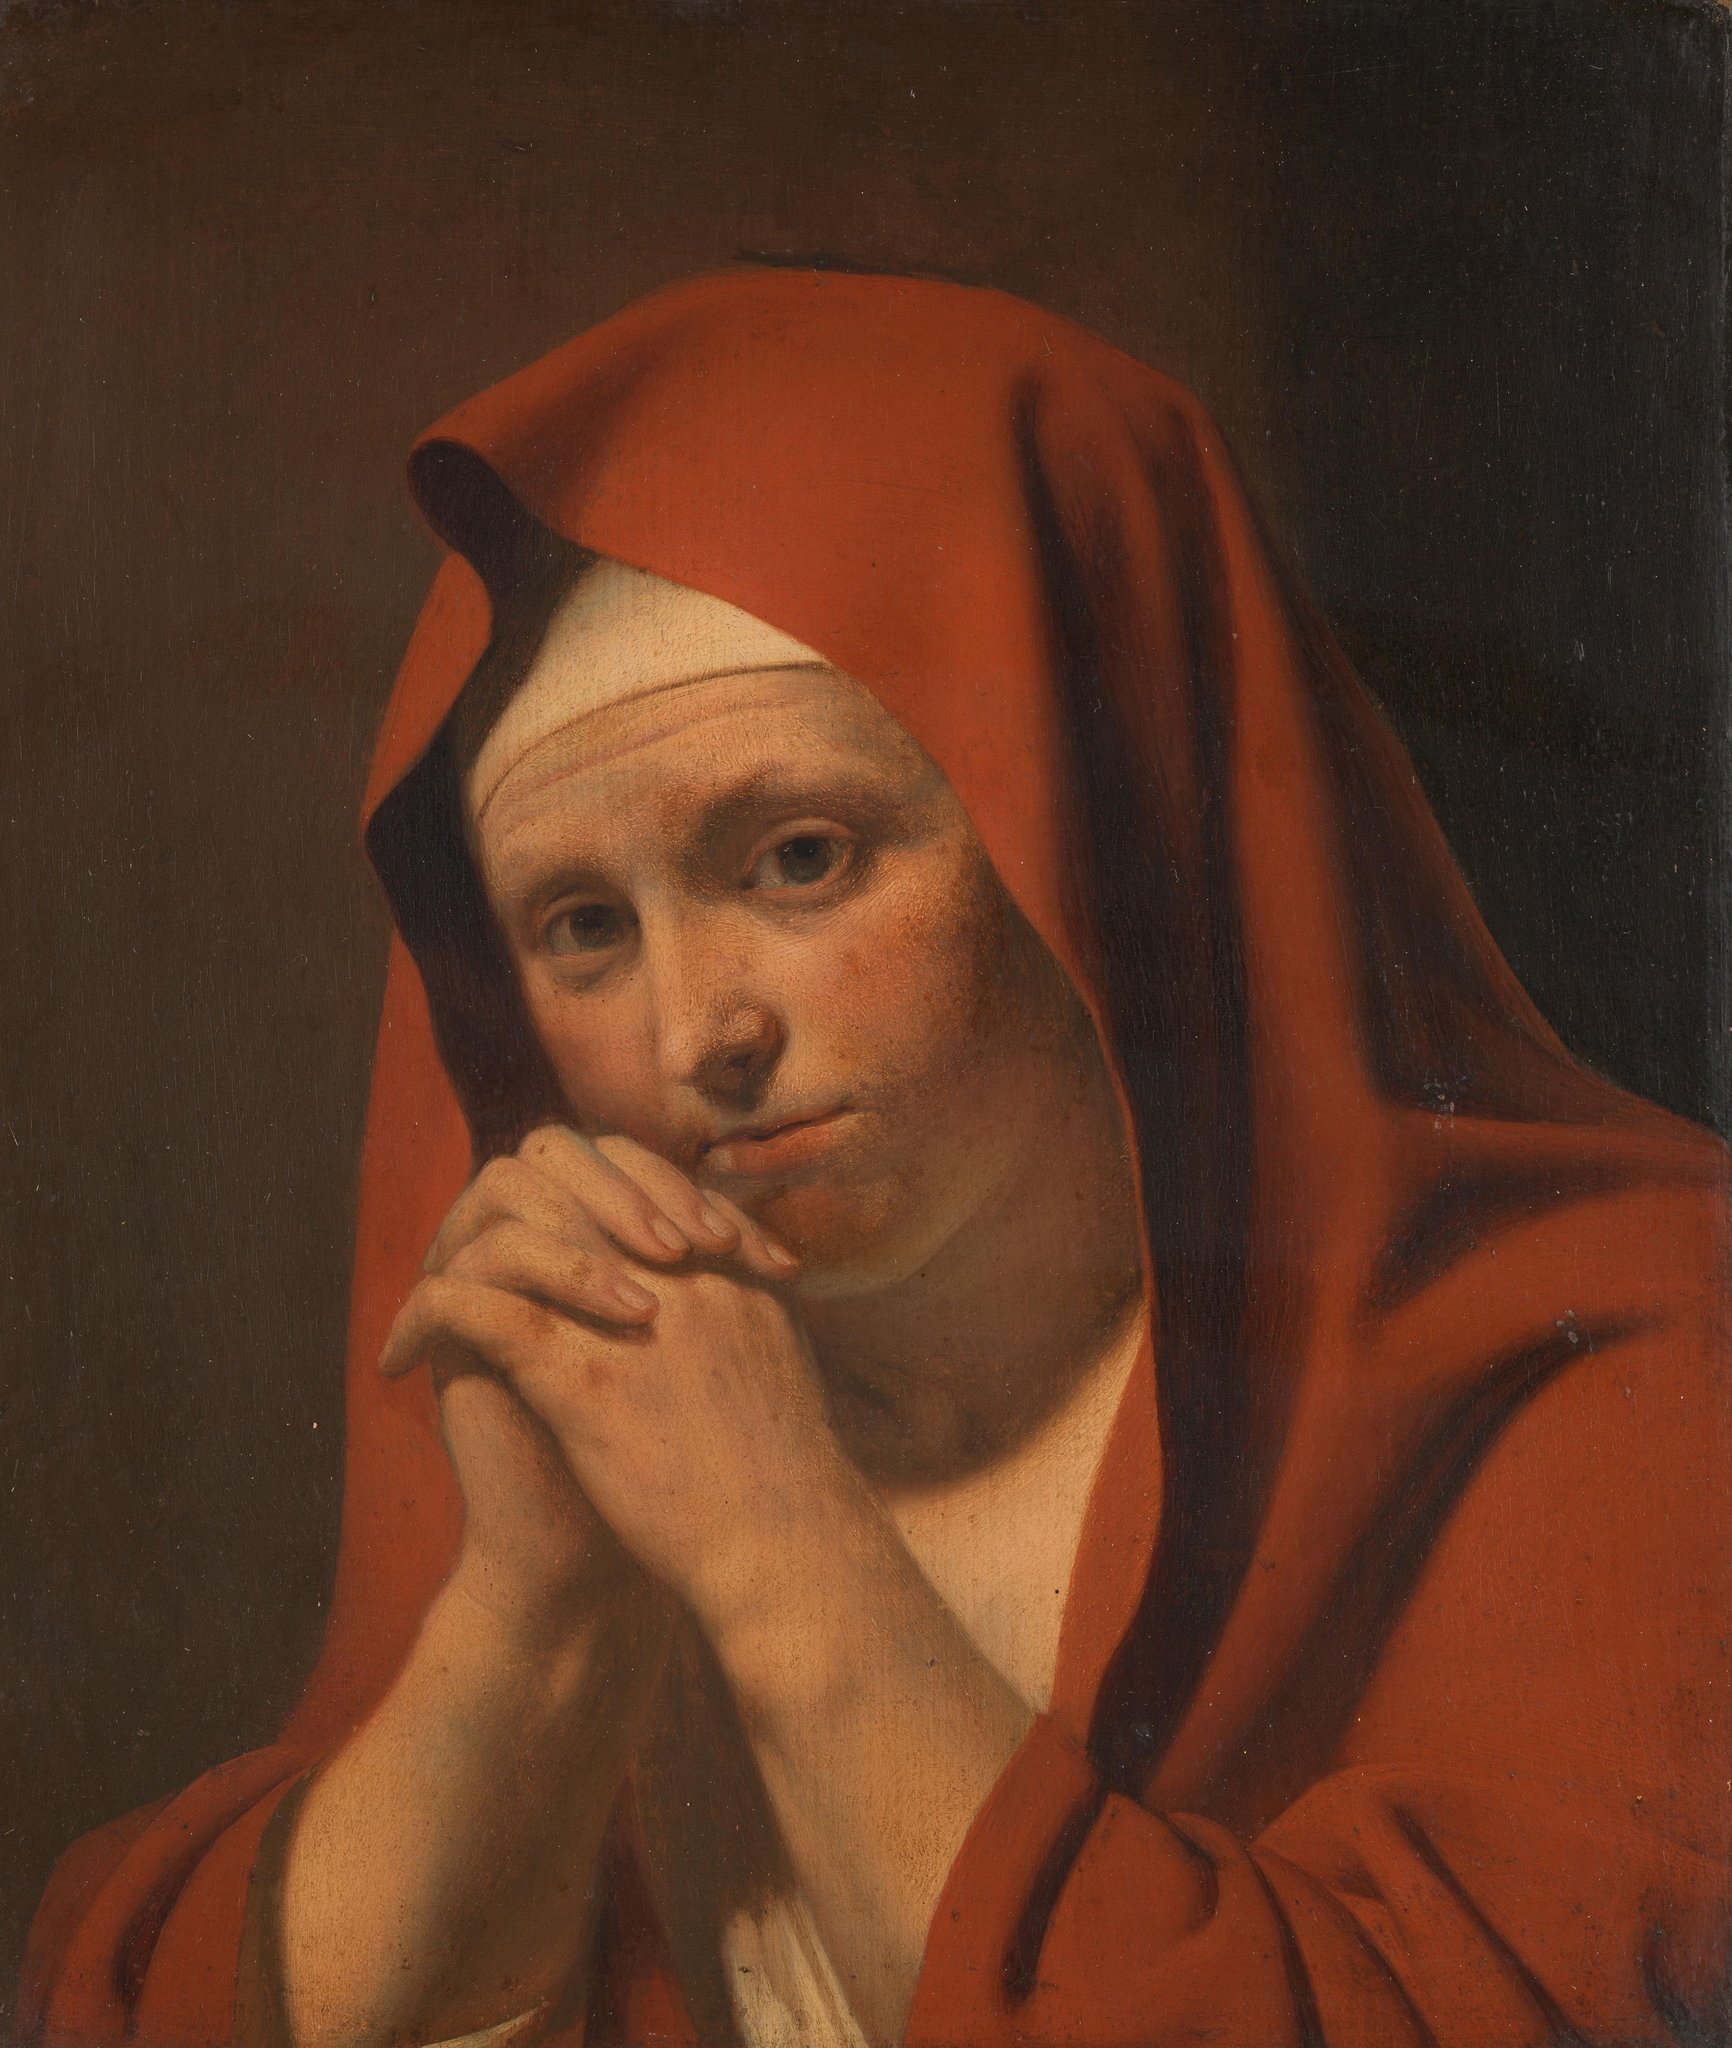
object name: painting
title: Woman Praying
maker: caesar van everdingen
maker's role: draughtsman, painter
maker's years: 1616-1678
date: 1650-1661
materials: oil, panel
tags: one person praying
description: Maria biddend, met haar handen voor haar gezicht gevouwen.